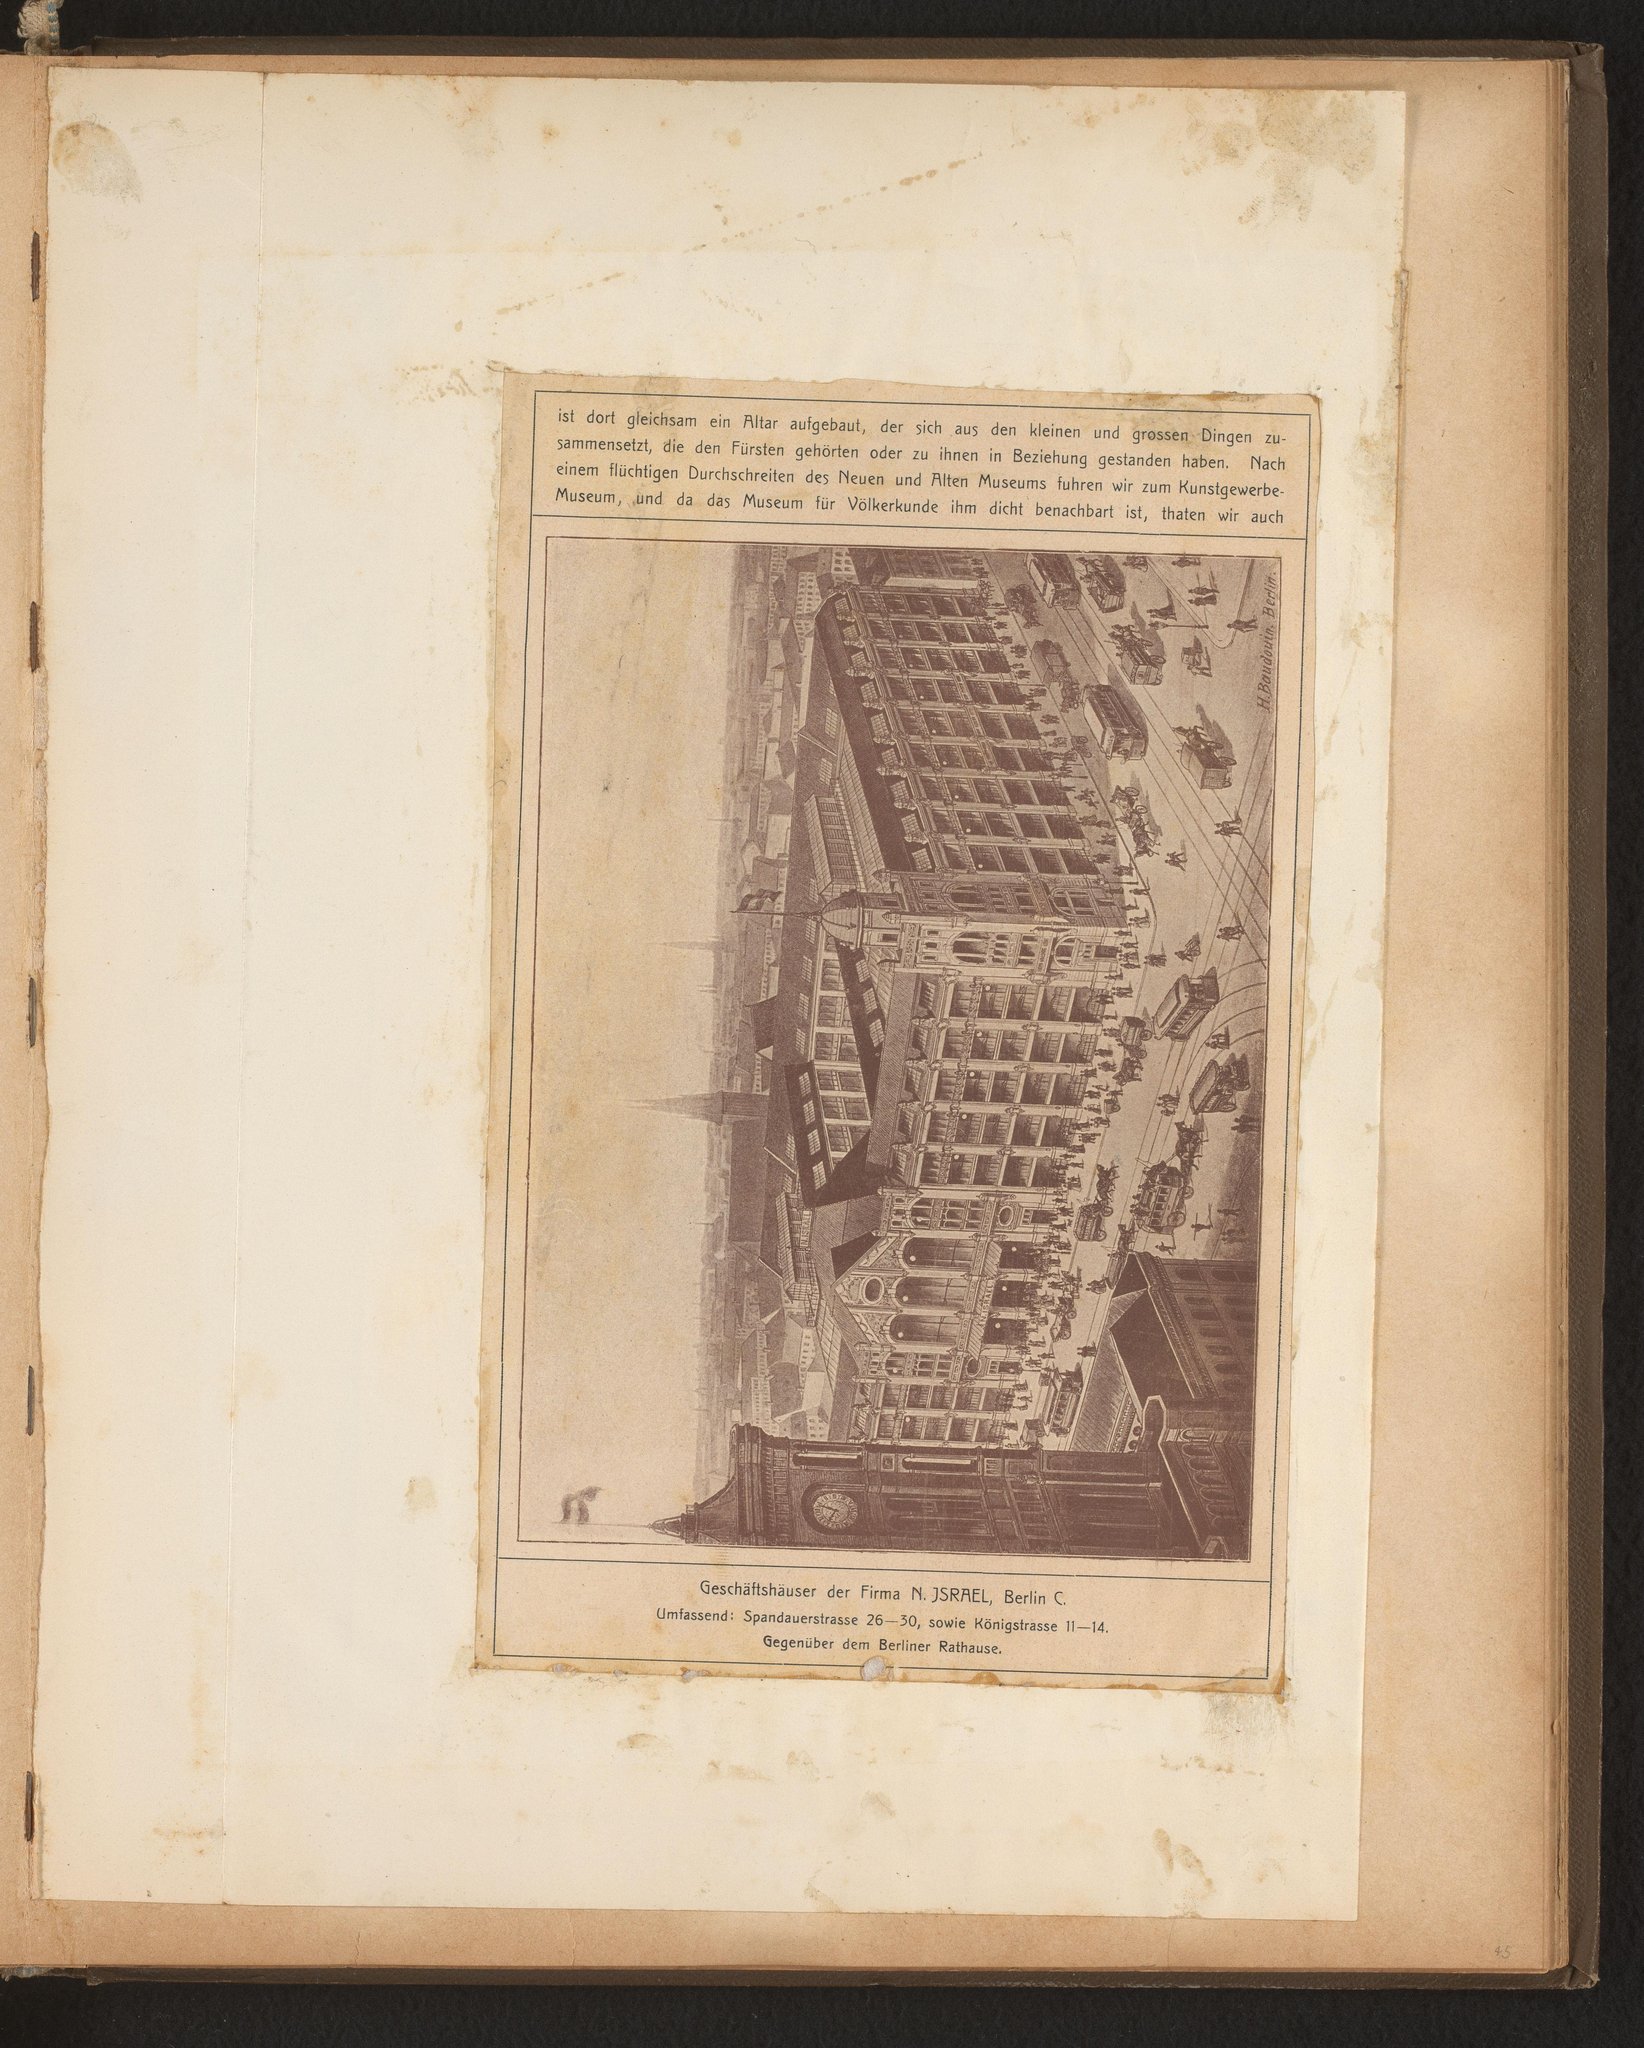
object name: reproduction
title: Reproductie van een tekening van een gezicht op warenhuis Nathan Israel, Berlijn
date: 1896-1901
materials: paper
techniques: autotype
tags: department store, supermarket, edifice, e.g.: public building, department store, berlin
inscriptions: inscription: ‘ist dort gleichsam (...) thaten wir auch’, inscription: ‘Geschäftshäuser der Firma N. Israel, Berlin C. (...)’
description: Deze fotomechanische afdruk maakt deel uit van een album.